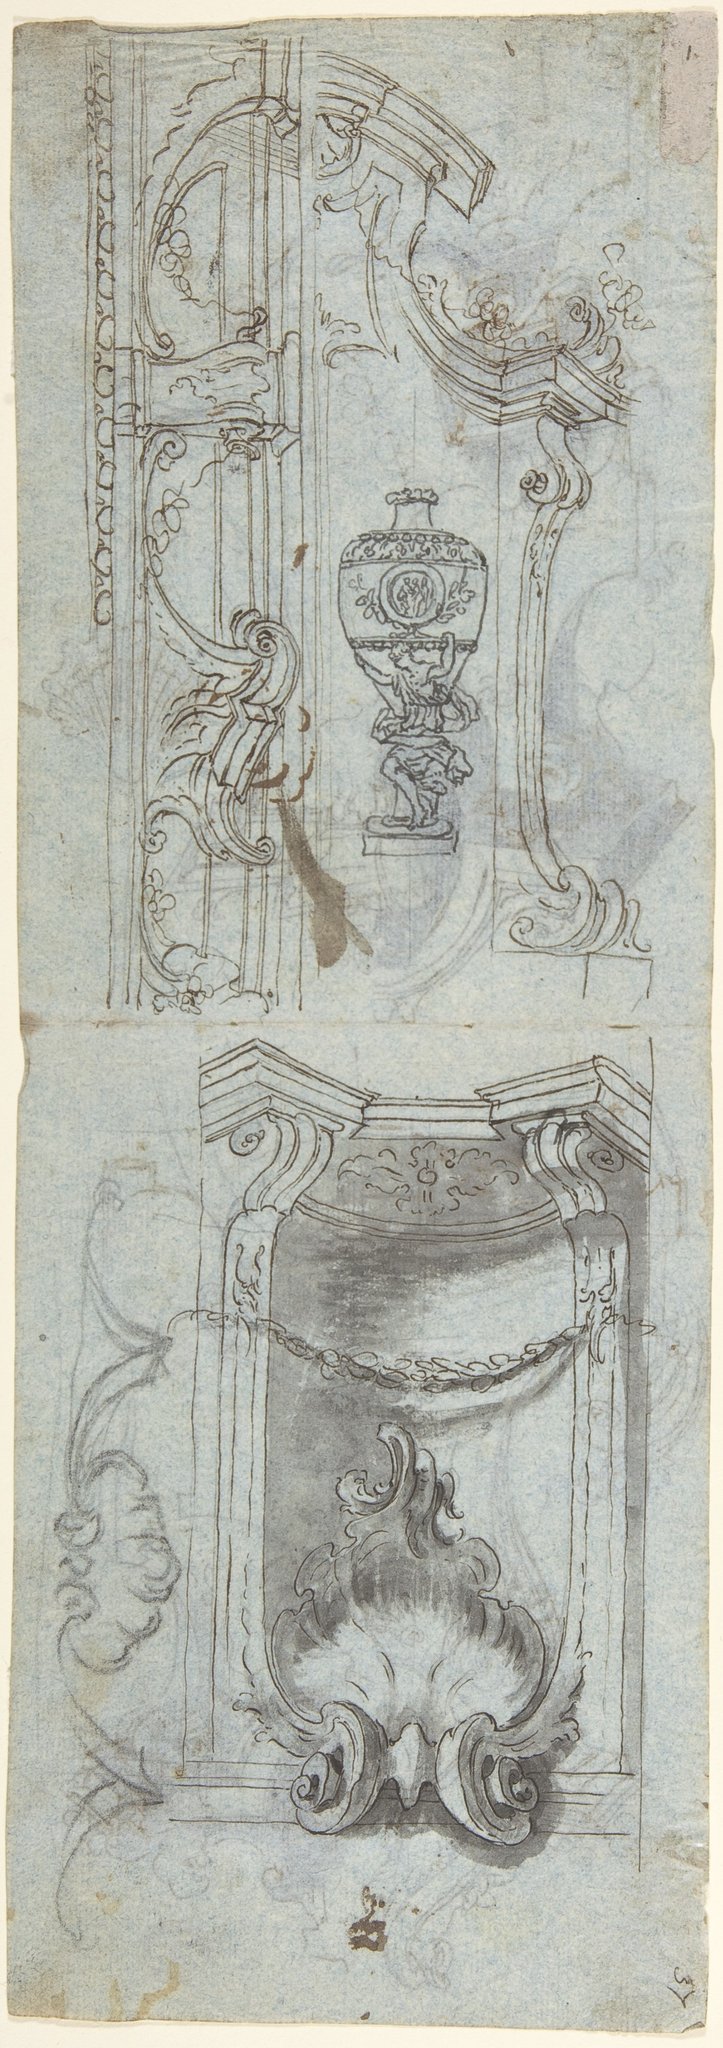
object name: drawing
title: Design of architectural ornaments and an Amphora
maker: anonymous, italian, piedmontese, 18th century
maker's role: artist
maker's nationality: italian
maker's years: 1700-1800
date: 1700-1780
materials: chalk, graphite, ink, drawing material, paper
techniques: brush, pen, wash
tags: ornament